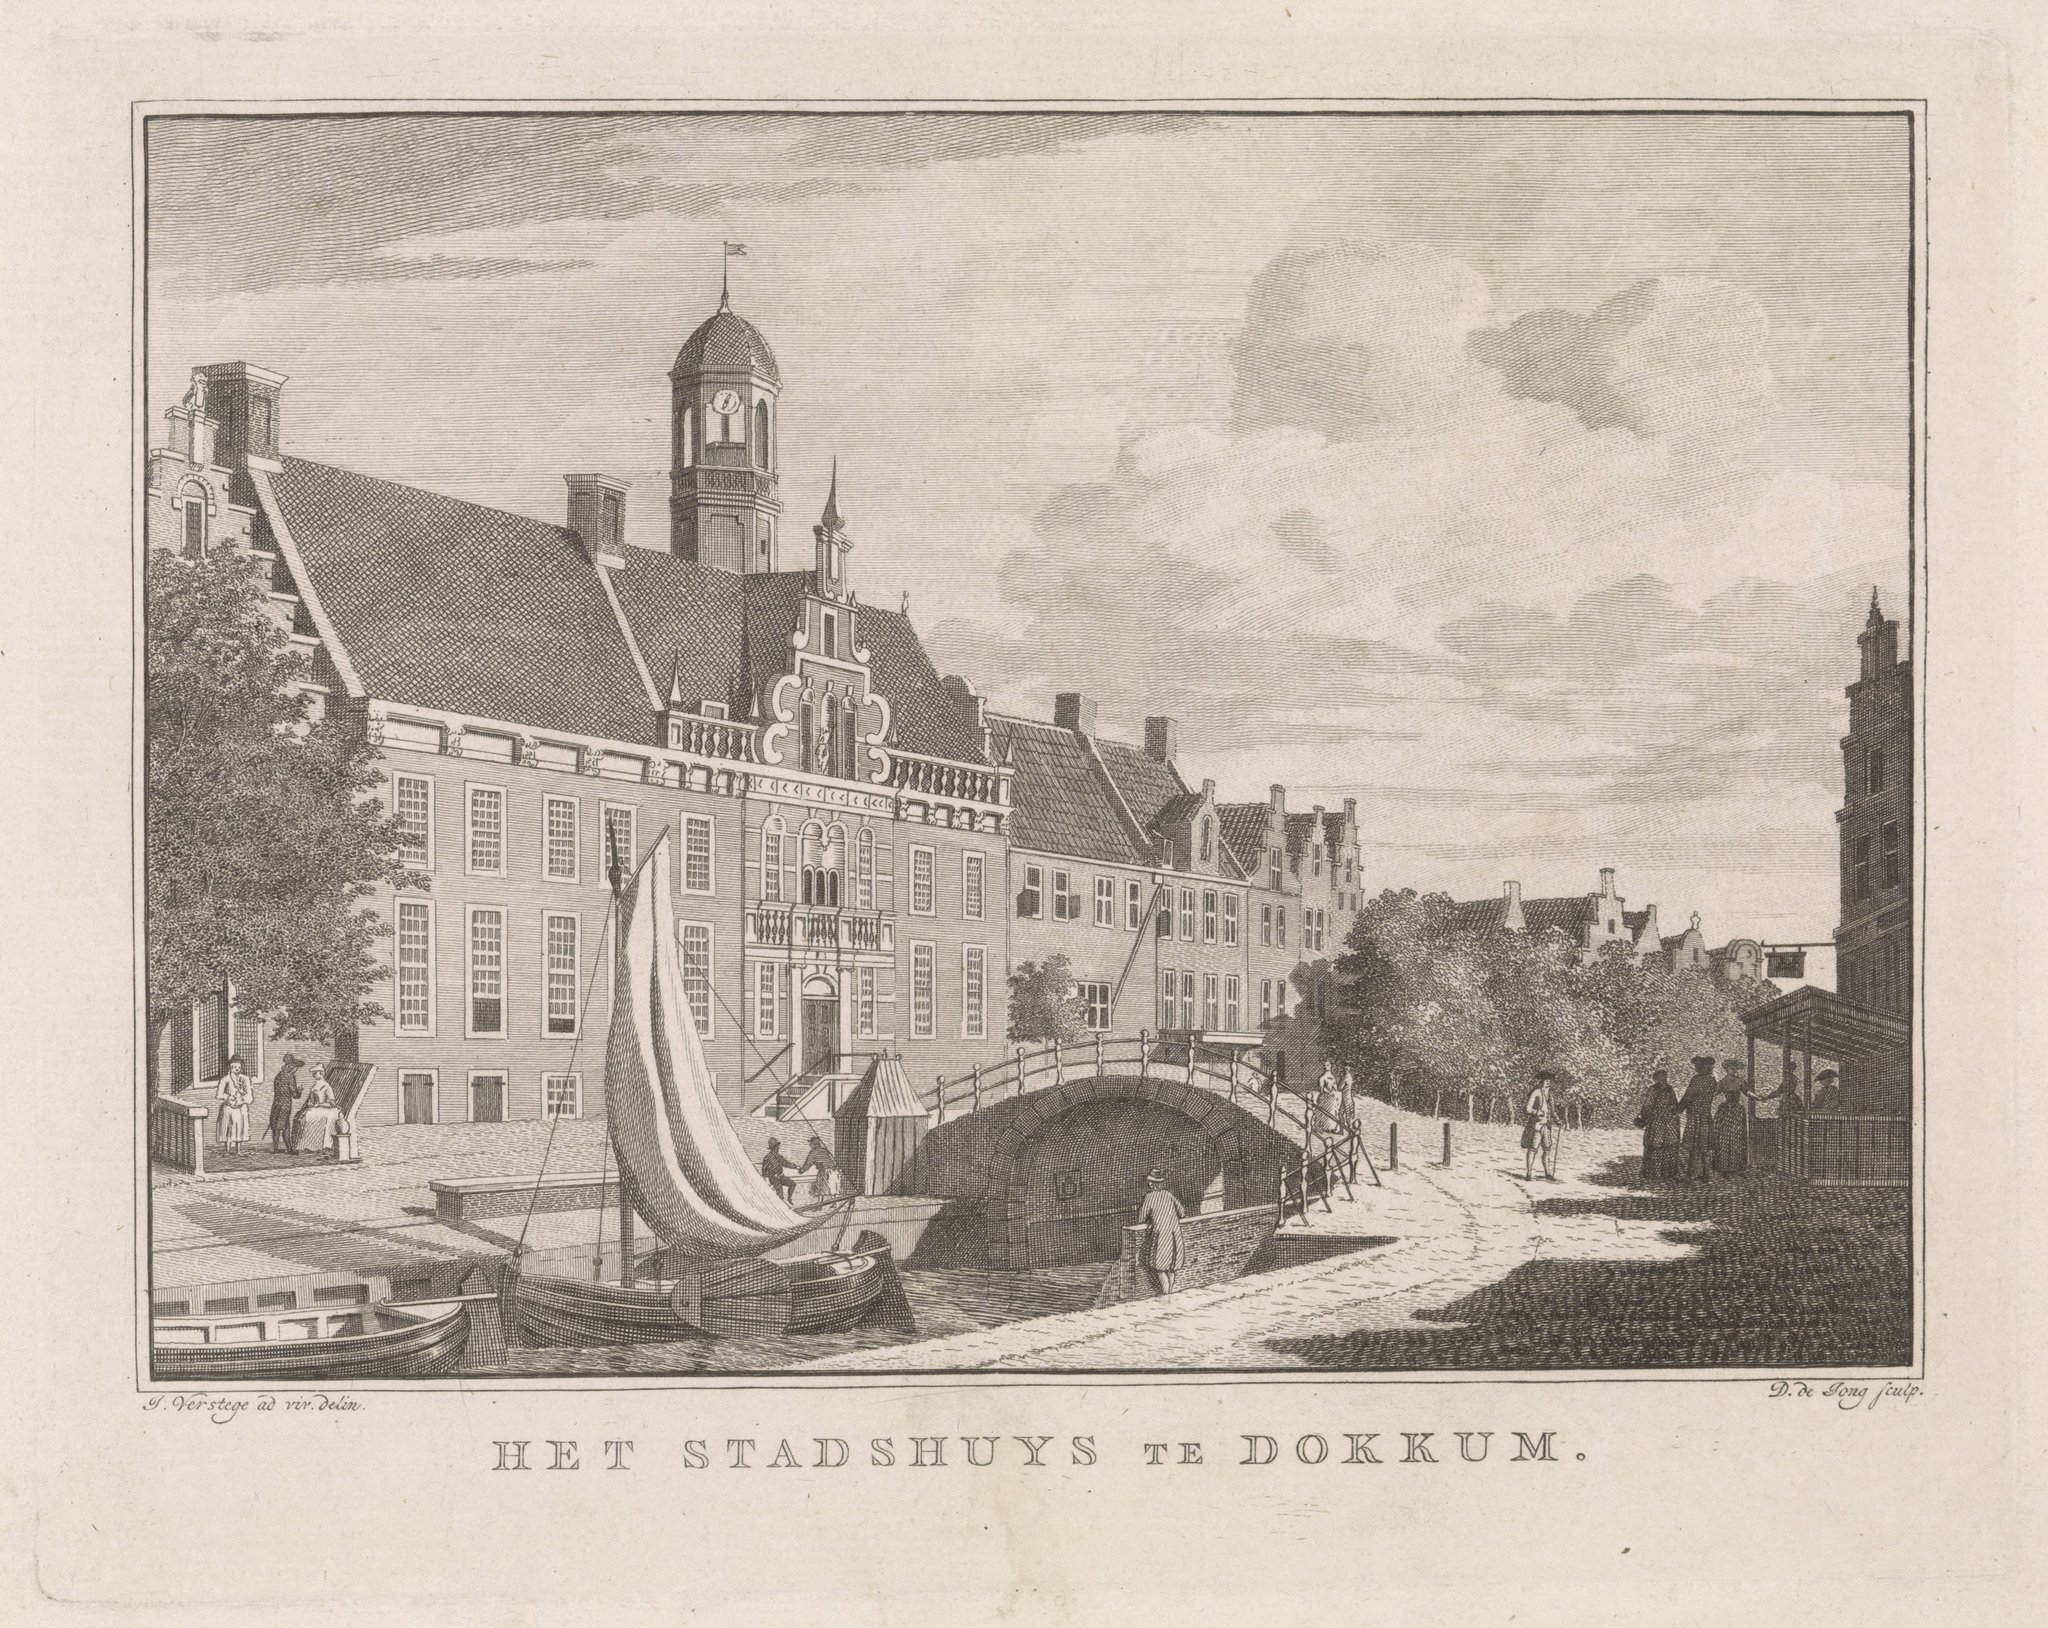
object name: print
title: Gezicht op stadhuis te Dokkum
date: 1779-1805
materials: paper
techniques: engraving, etching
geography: northern netherlands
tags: townhall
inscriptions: collector's mark: Lugt 2228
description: Gezicht op het stadhuis te Dokkum. Op de voorgrond een brug en boten op het water. In de marge een onderschrift in het Nederlands.